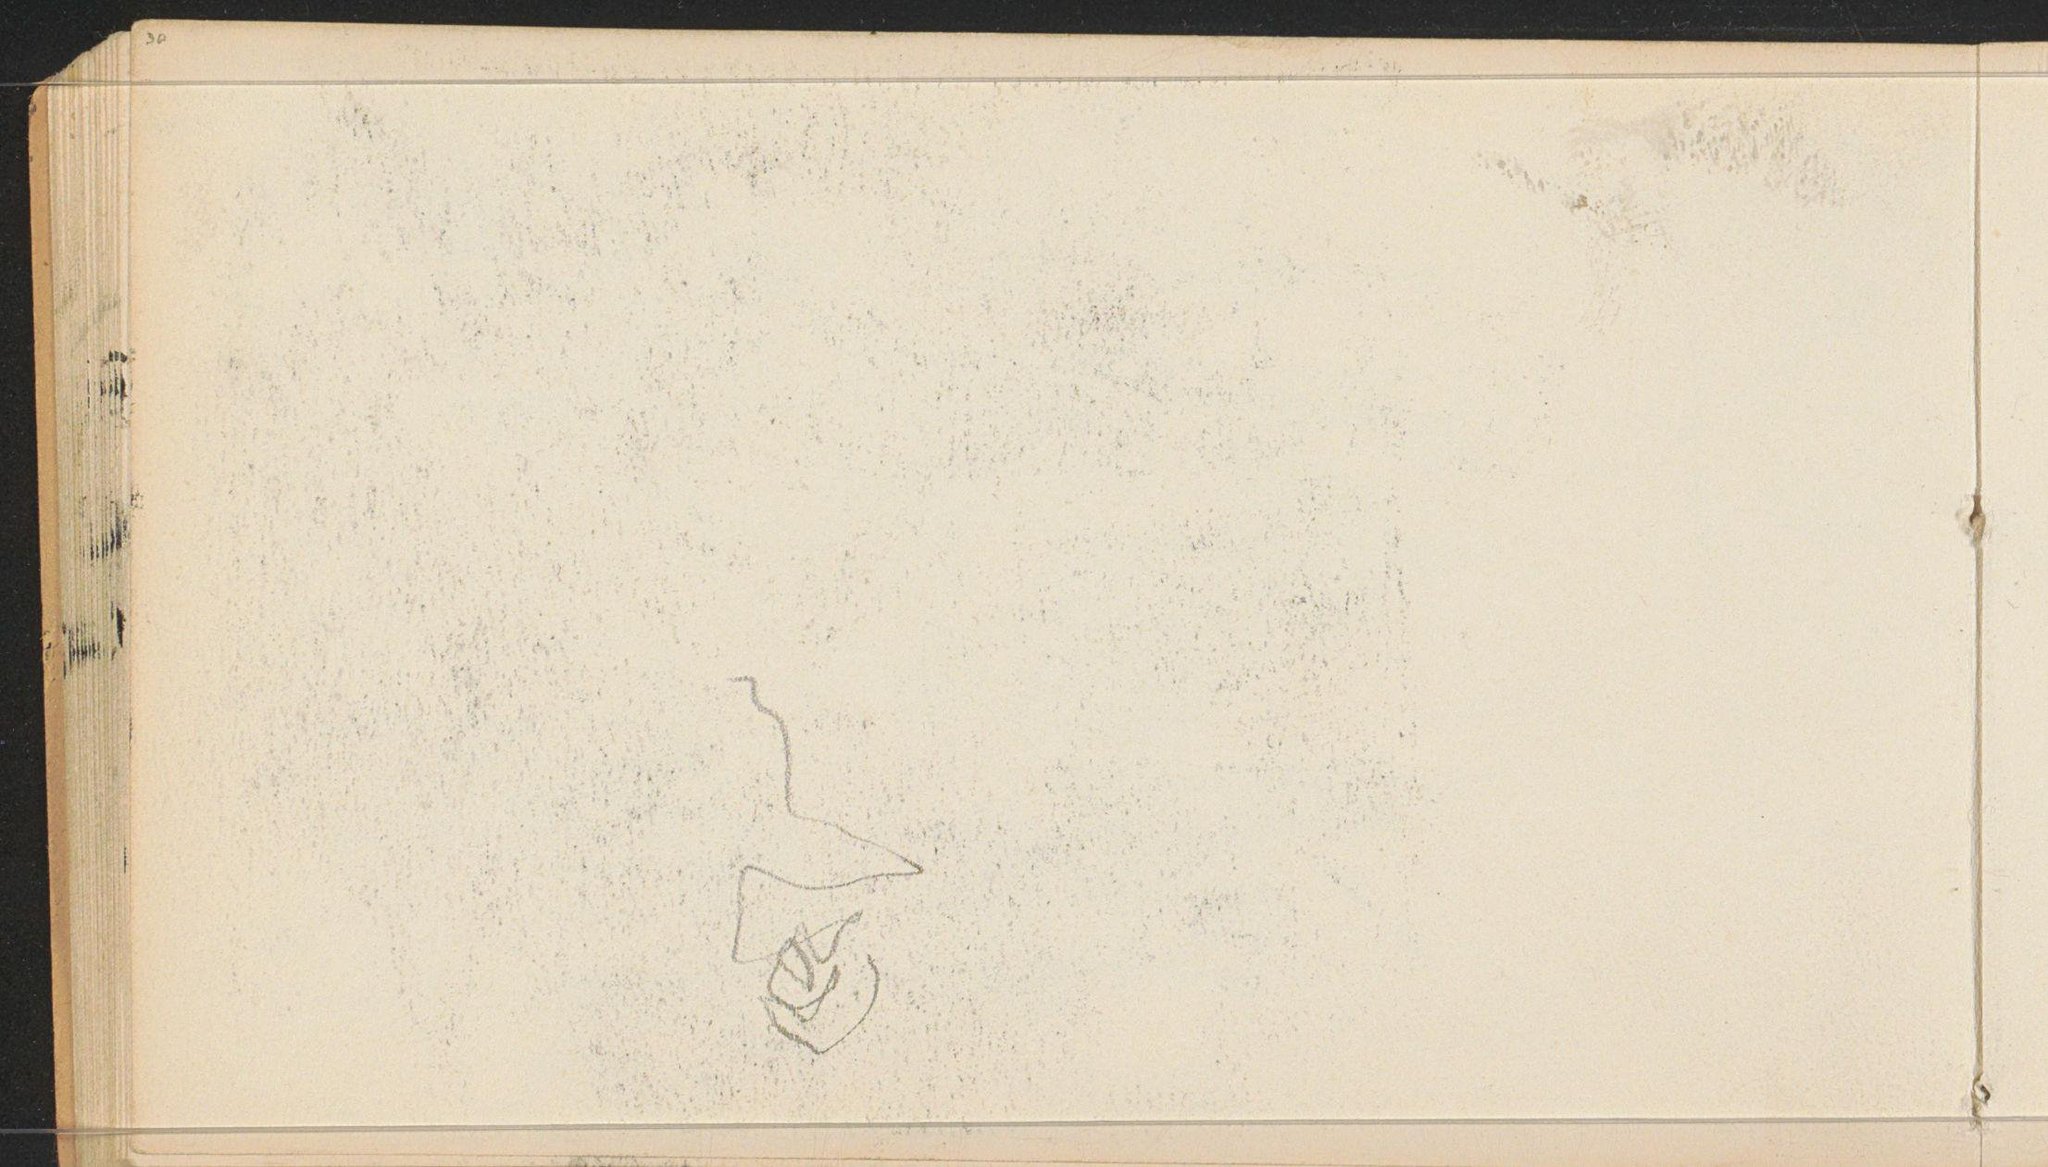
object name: sketchbook leaf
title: Studie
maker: marius bauer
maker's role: draughtsman, print maker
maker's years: 1867-1932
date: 1922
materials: paper, pencil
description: Pagina 30 uit een schetsboek met 31 bladen.